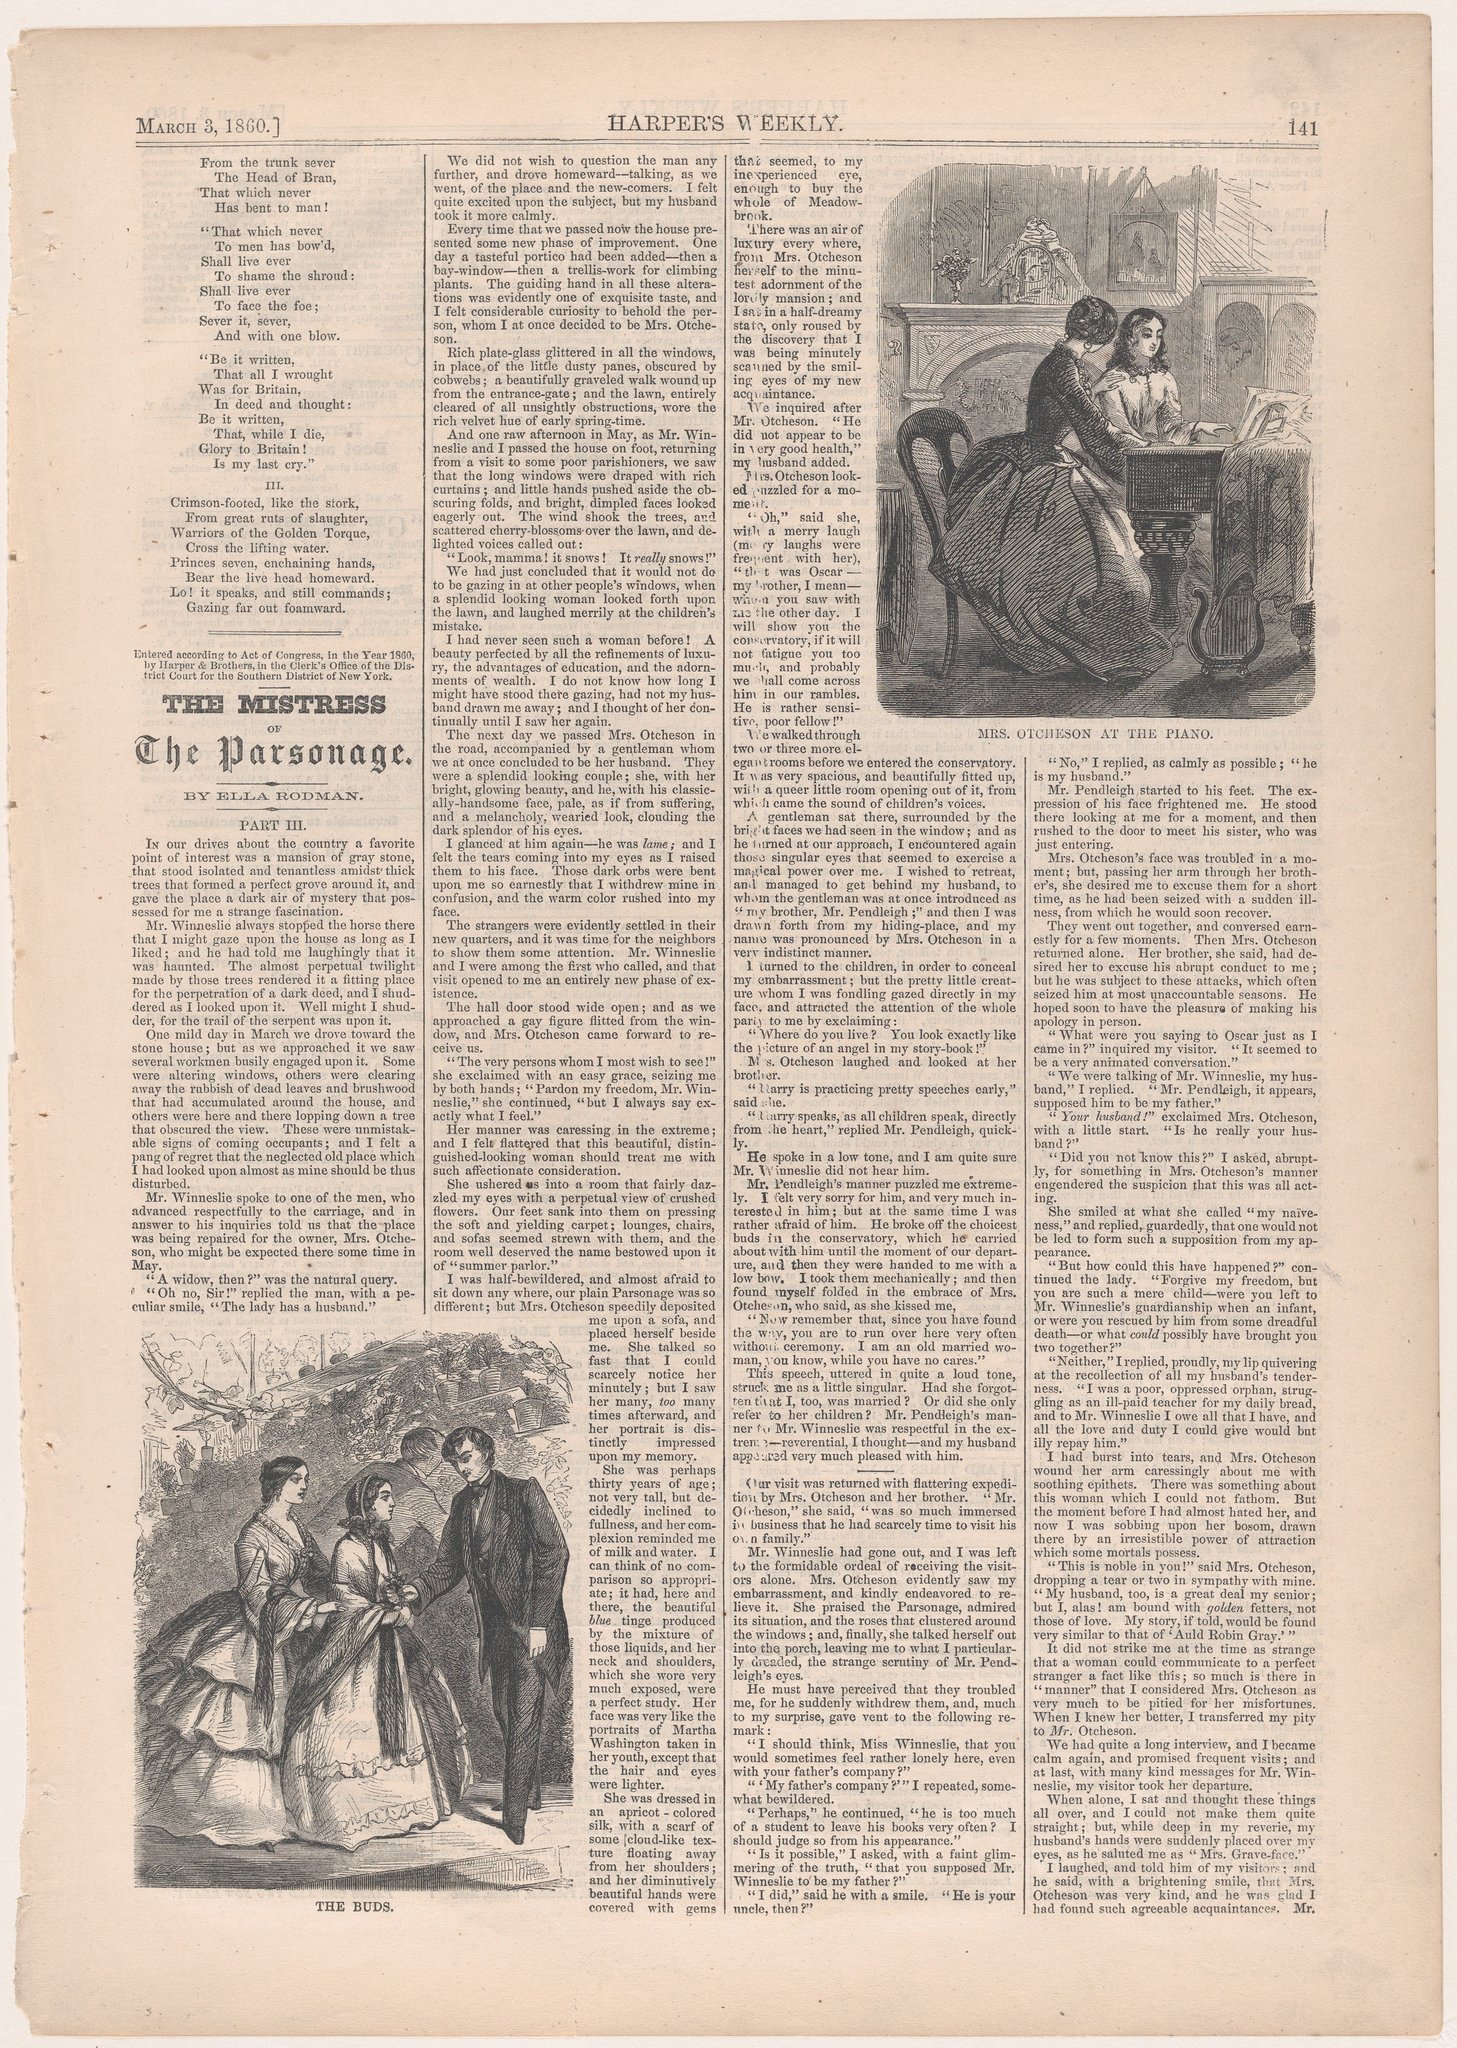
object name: print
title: Mrs. Otcheson at the Piano, and The Buds (from "The Mistress of the Parsonage," in "Harper's Weekly")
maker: winslow homer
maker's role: artist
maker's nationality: american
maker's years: 1836-1910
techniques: engraving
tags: men,women